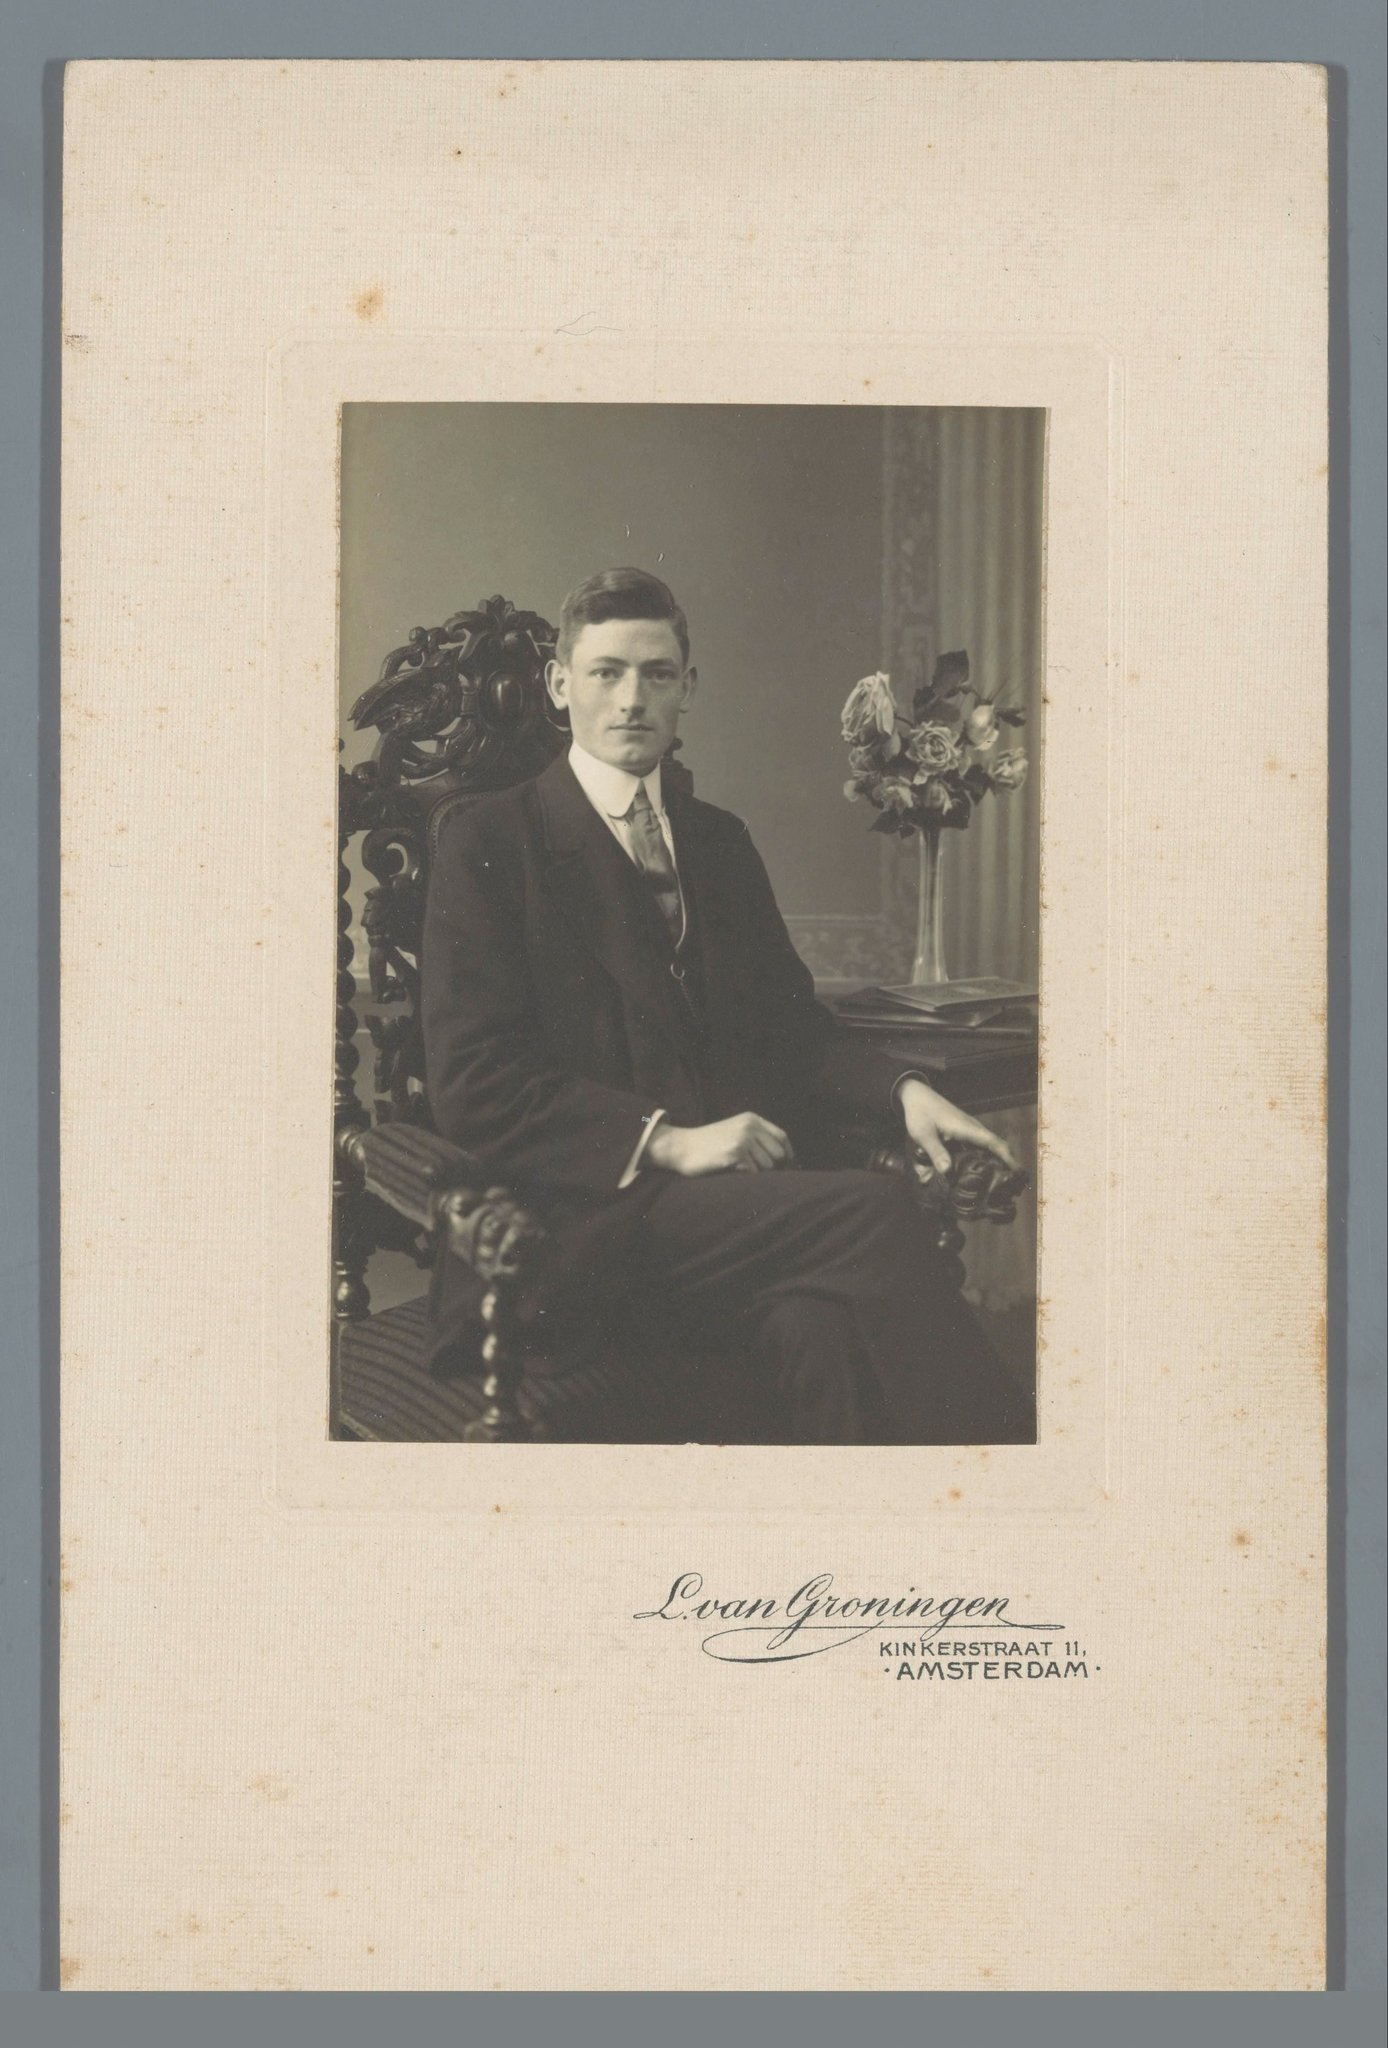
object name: cabinet photograph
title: Portret van een onbekende man in een stoel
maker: laurus van groningen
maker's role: fotograaf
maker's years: 1871-1965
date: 1880-1920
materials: cardboard, photographic support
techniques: gelatin silver print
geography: amsterdam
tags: adult man, chair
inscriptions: number: ‘fam de [...] 8272’, name: ‘L. van Groningen Kinkerstraat 11 Amsterdam’